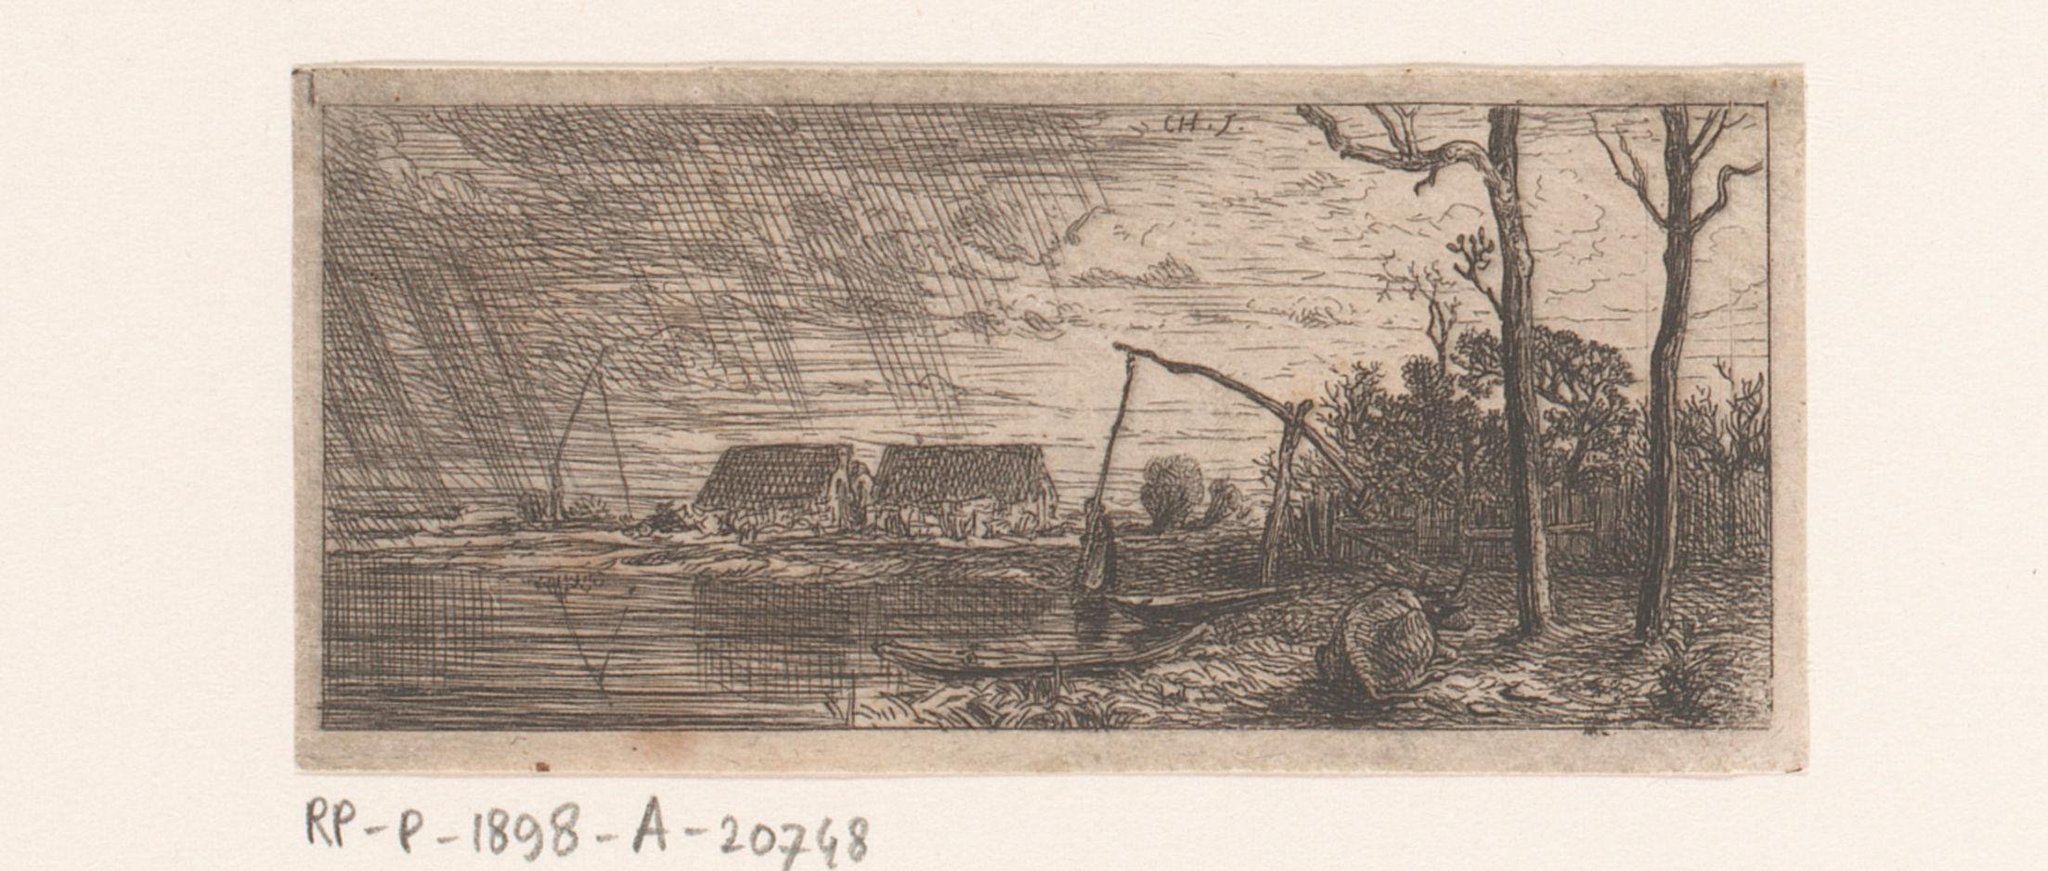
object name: print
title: Rivierlandschap met liggende koe en een vrouw aan de oever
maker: charles emile jacque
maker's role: draughtsman, painter, print maker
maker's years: 1813-1894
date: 1844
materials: paper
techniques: engraving, etching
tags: river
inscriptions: collector's mark: Lugt 964